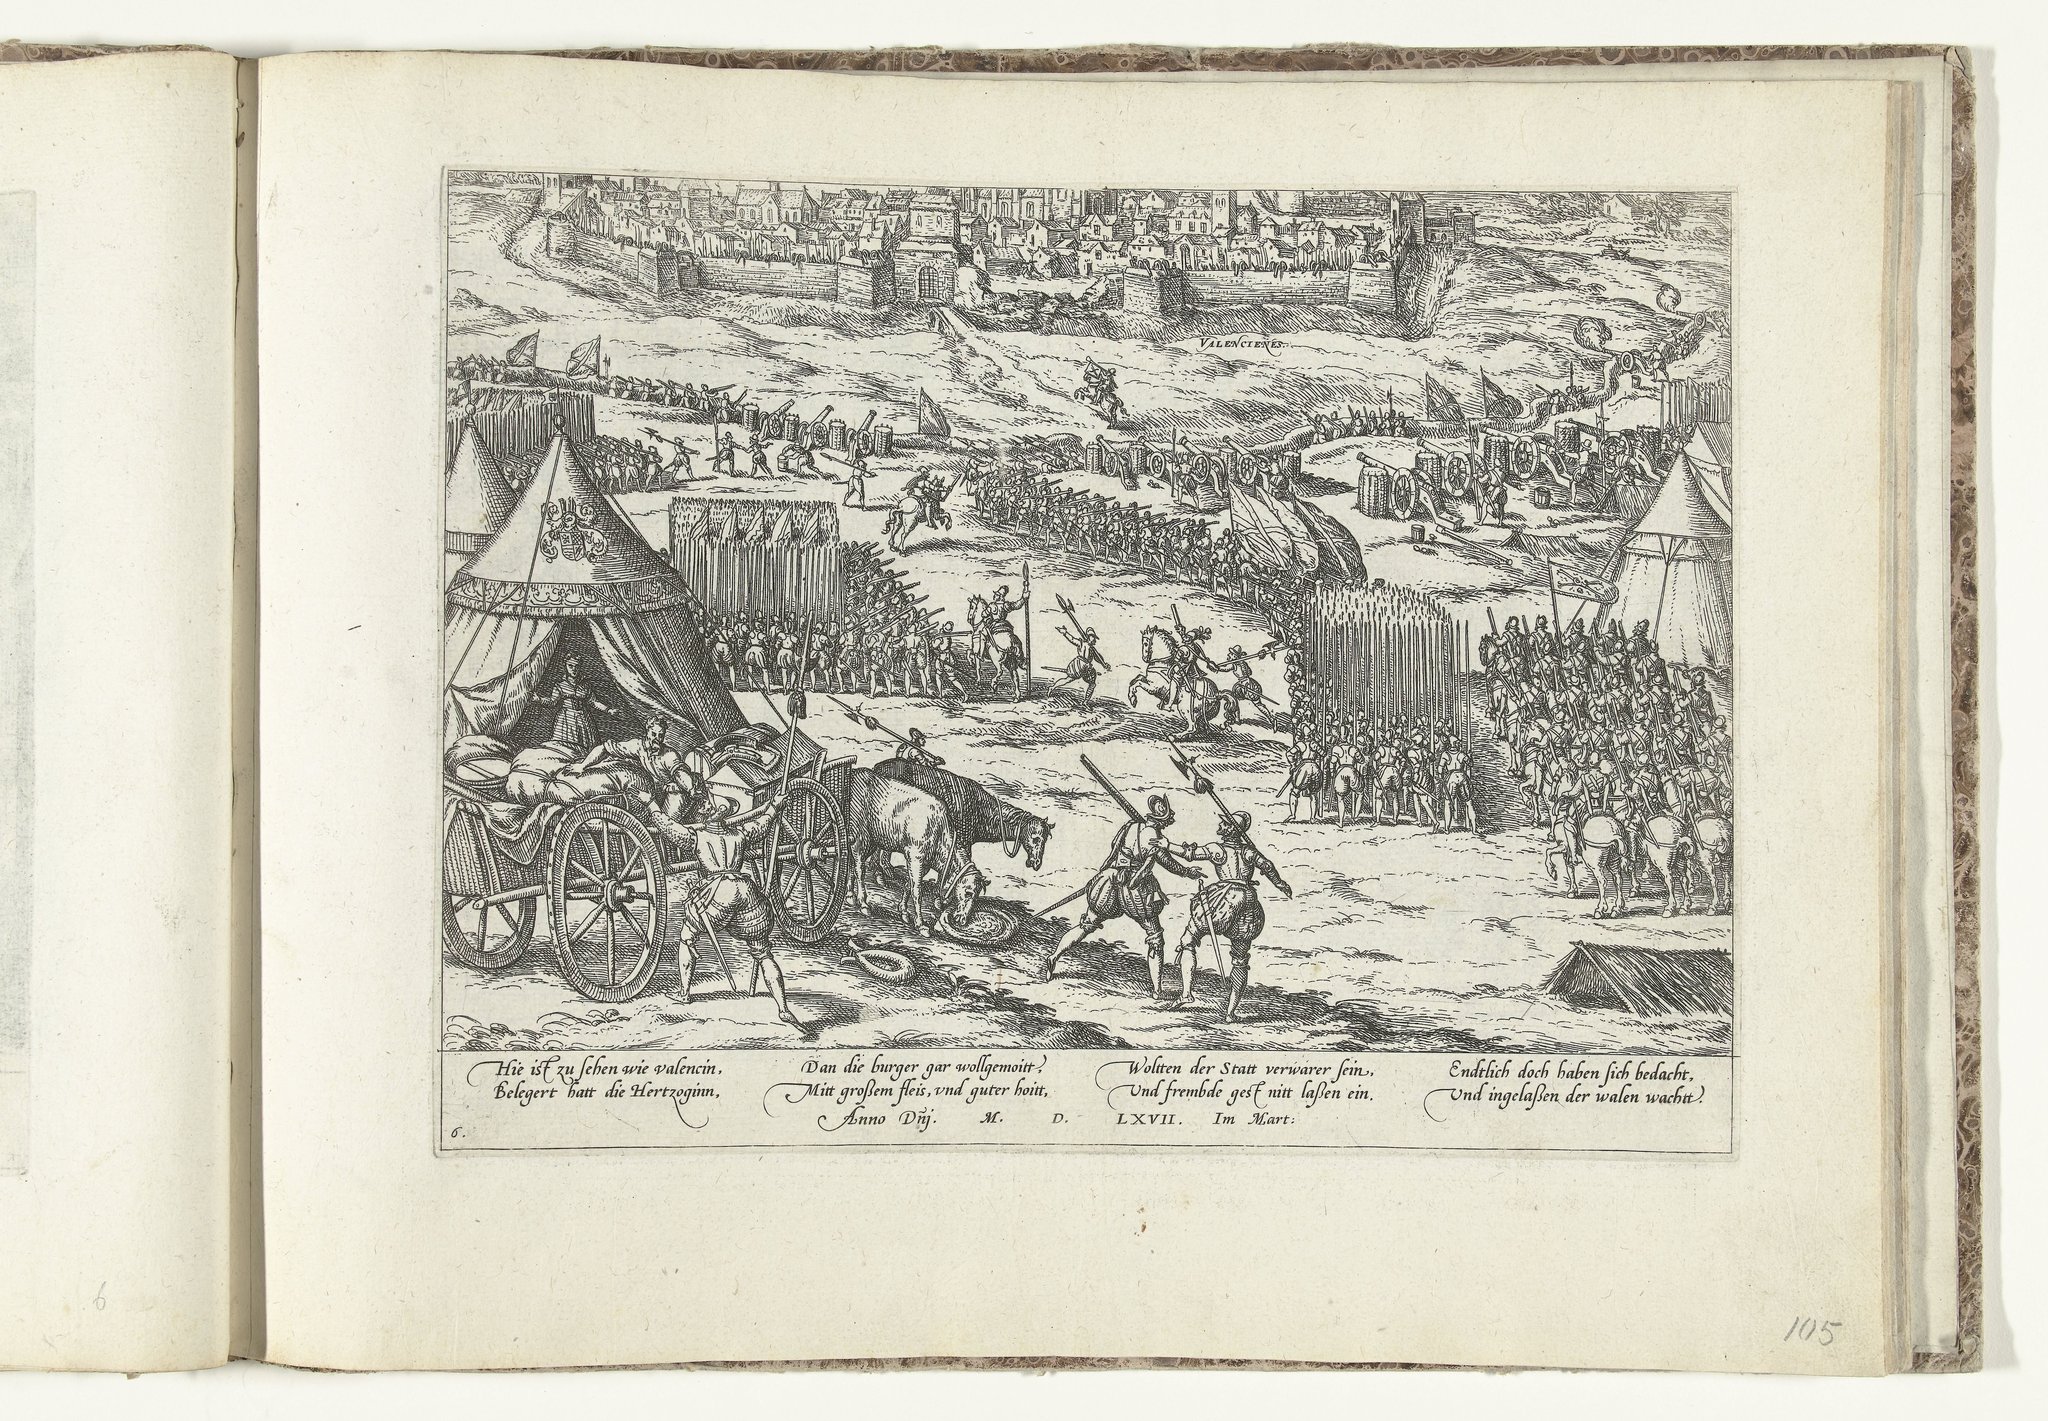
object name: print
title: Serie 5: Nederlandse Gebeurtenissen, 1566-1570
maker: frans hogenberg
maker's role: print maker, publisher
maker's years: 1538-1590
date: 1567-1570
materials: paper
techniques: etching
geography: cologne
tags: capture of city (after the siege)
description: Inname van Valenciennes. De stad wordt door de heer van Noircarmes heroverd op de calvinisten, maart 1567. Gezicht vanuit het legerkamp van Noircarmes op de stad. Met onderschrift van 8 regels in het Duits. Genummerd: 6. De prent maakt deel uit van een album.